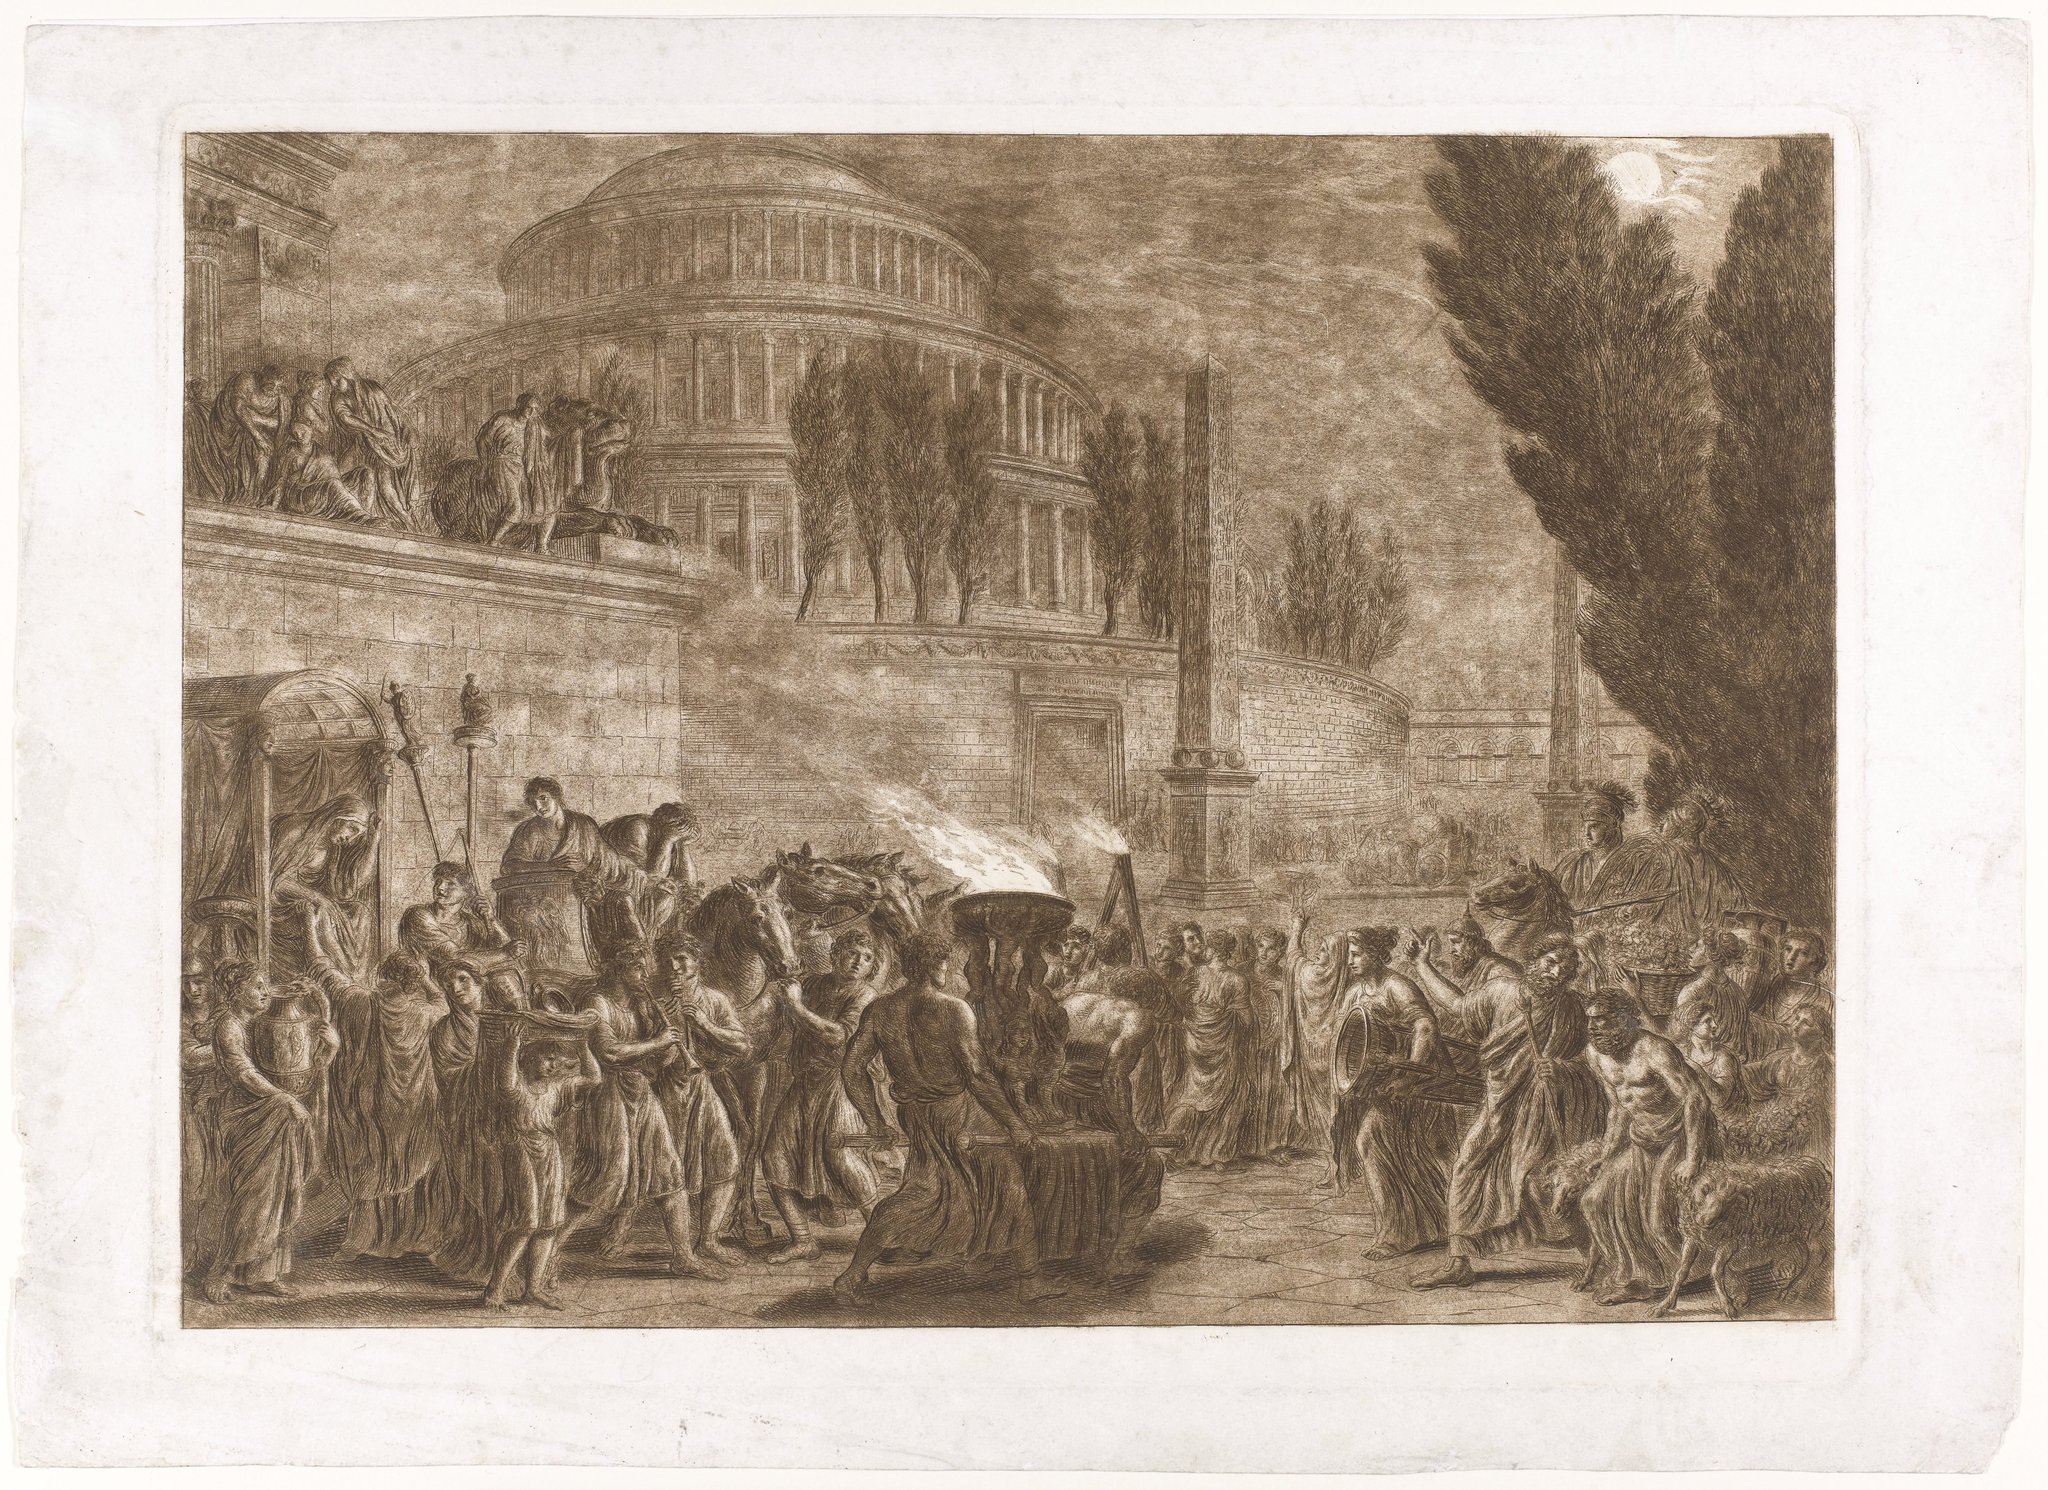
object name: print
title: Optocht bij antieke tempel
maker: luigi ademollo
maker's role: draughtsman, painter, print maker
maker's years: 1764-1849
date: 1774-1849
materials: paper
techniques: aquatint, etching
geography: italy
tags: triumphal entry and public reception, pageant, 'entrée solennelle', 'joyeuse entrée', temple, shrine ~ roman religion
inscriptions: collector's mark: Lugt 2228, collector's mark: Lugt 2760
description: Voor een antieke tempel en een obelisk langs gaat een optocht van mannen die een vuurbekken dragen, muzikanten, soldaten te paard, een vrouw in een overhuifde wagen, mensen met kannen, manden en rammen.